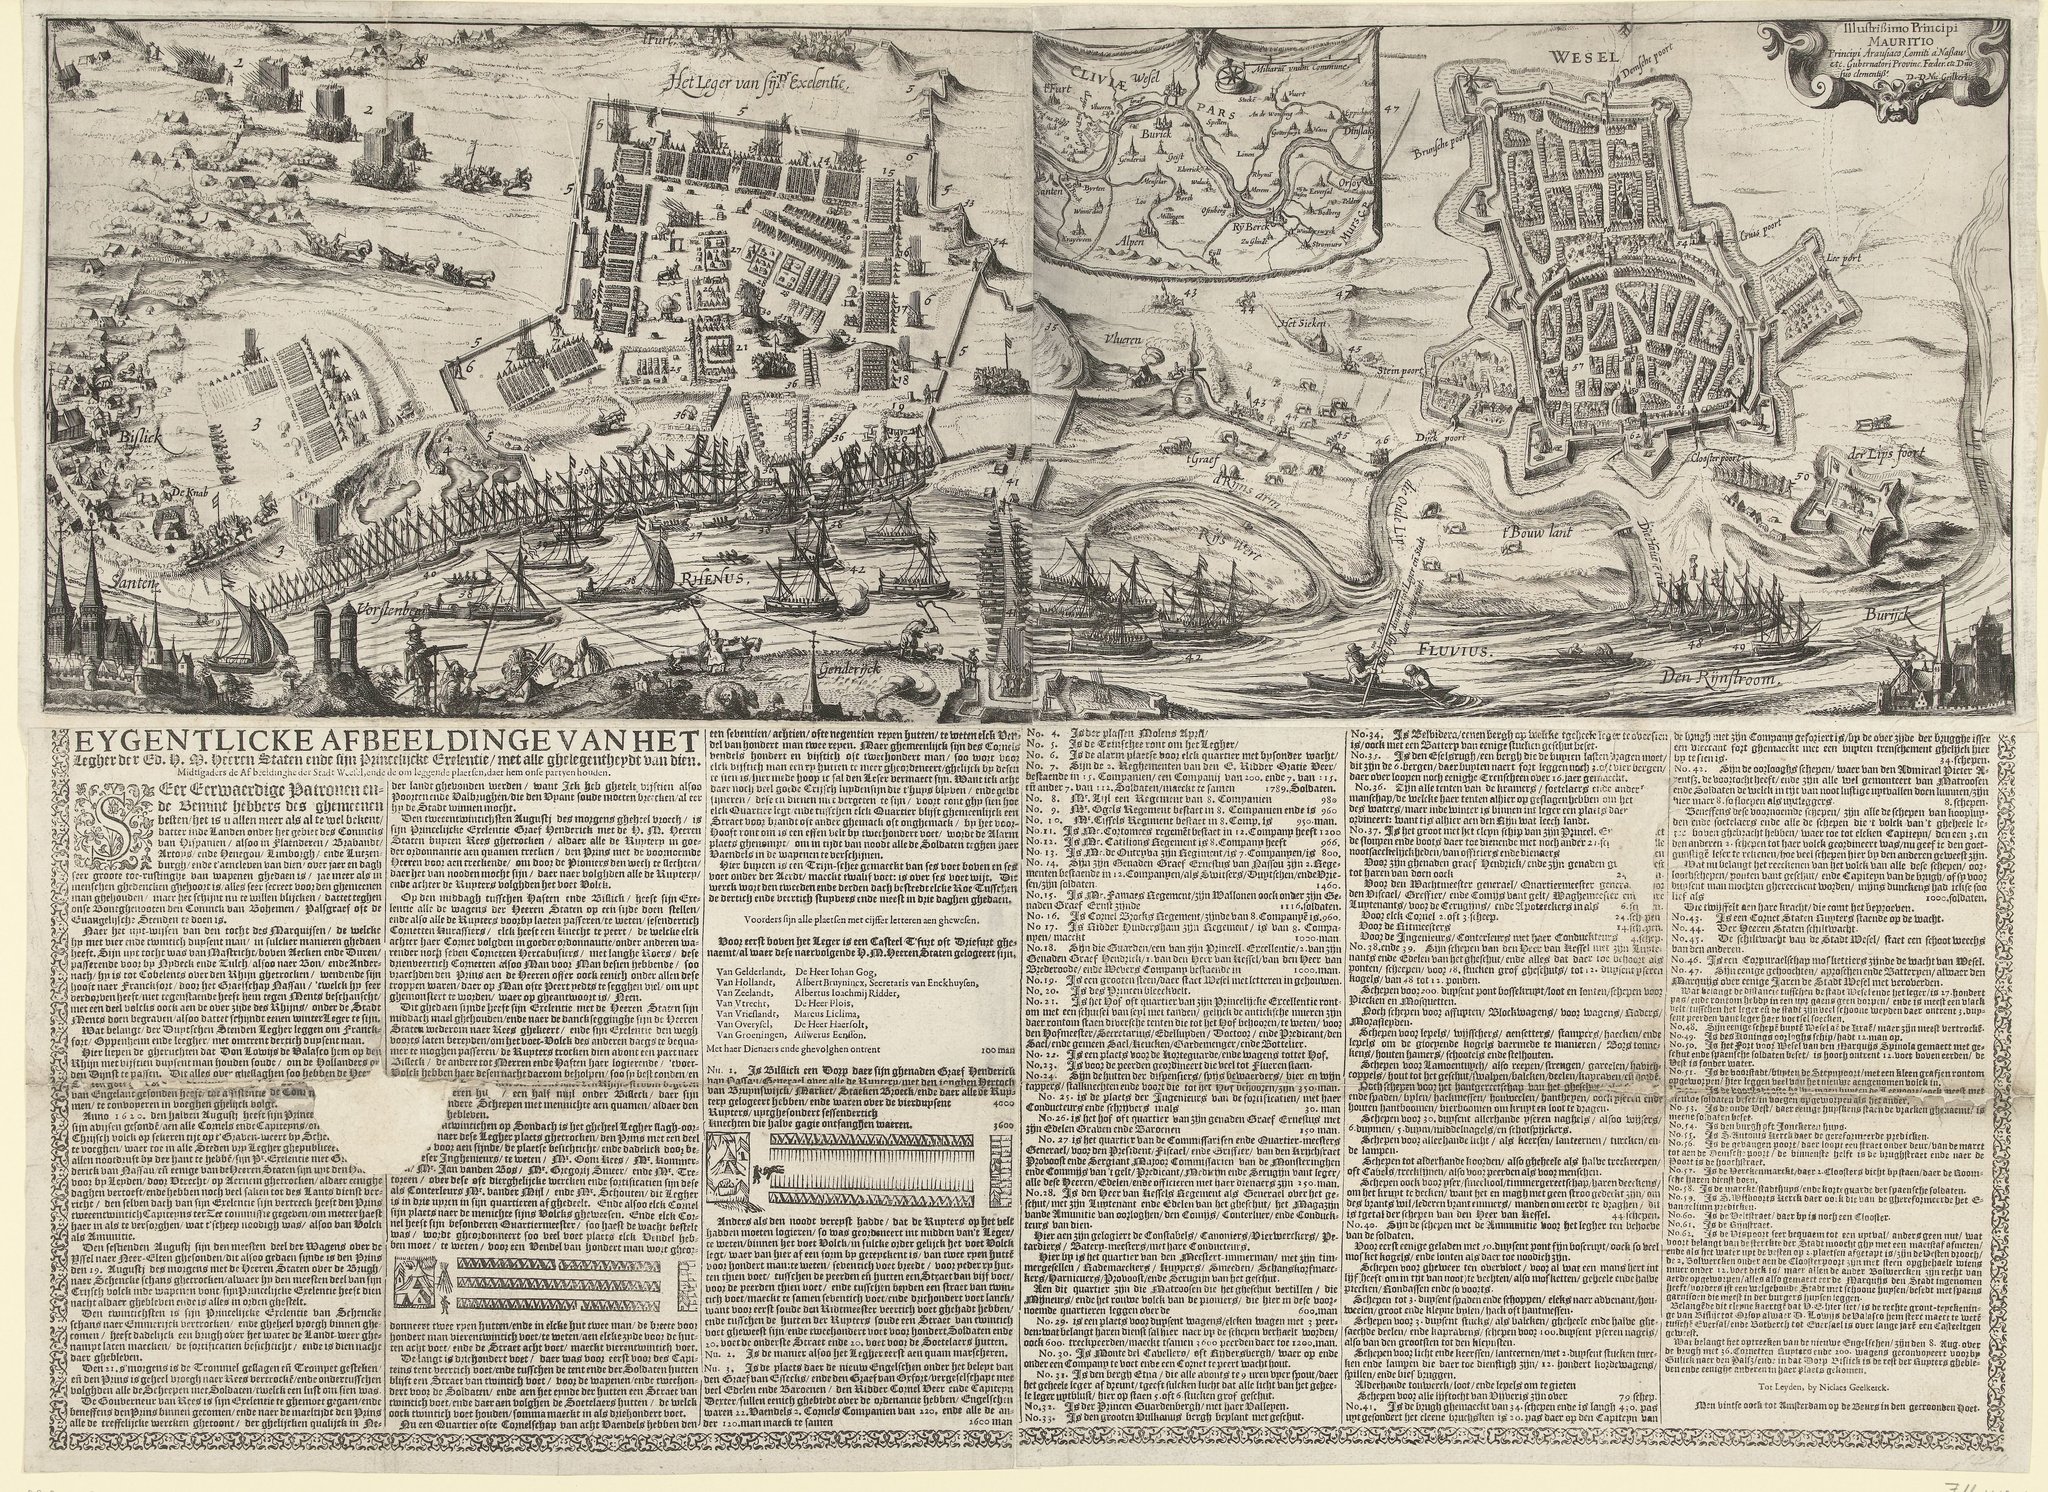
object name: print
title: Tocht van Maurits naar Wesel tegen Spinola, 1620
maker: nicolaes van geelkercken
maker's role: print maker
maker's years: 1585-1656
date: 1620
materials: paper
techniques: etching, letterpress printing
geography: leiden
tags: the hague, maurice (prince of orange), troop movements, transportation, (military) camp with tents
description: Groot blad met de tocht van prins Maurits naar Wesel tegen Spinola, 15 augustus 1620. Onderaan de rivier de Rijn met schepen van de Staatse vloot, links het legerkamp van prins Maurits, rechts de stad Wesel. Hiertussen een kaartje van het land van Kleef. De voorstelling gedrukt van twee platen, hieronder vastgeplakt twee tekstbladen met zes kolommen tekst waarin twee simpele illustraties staan.